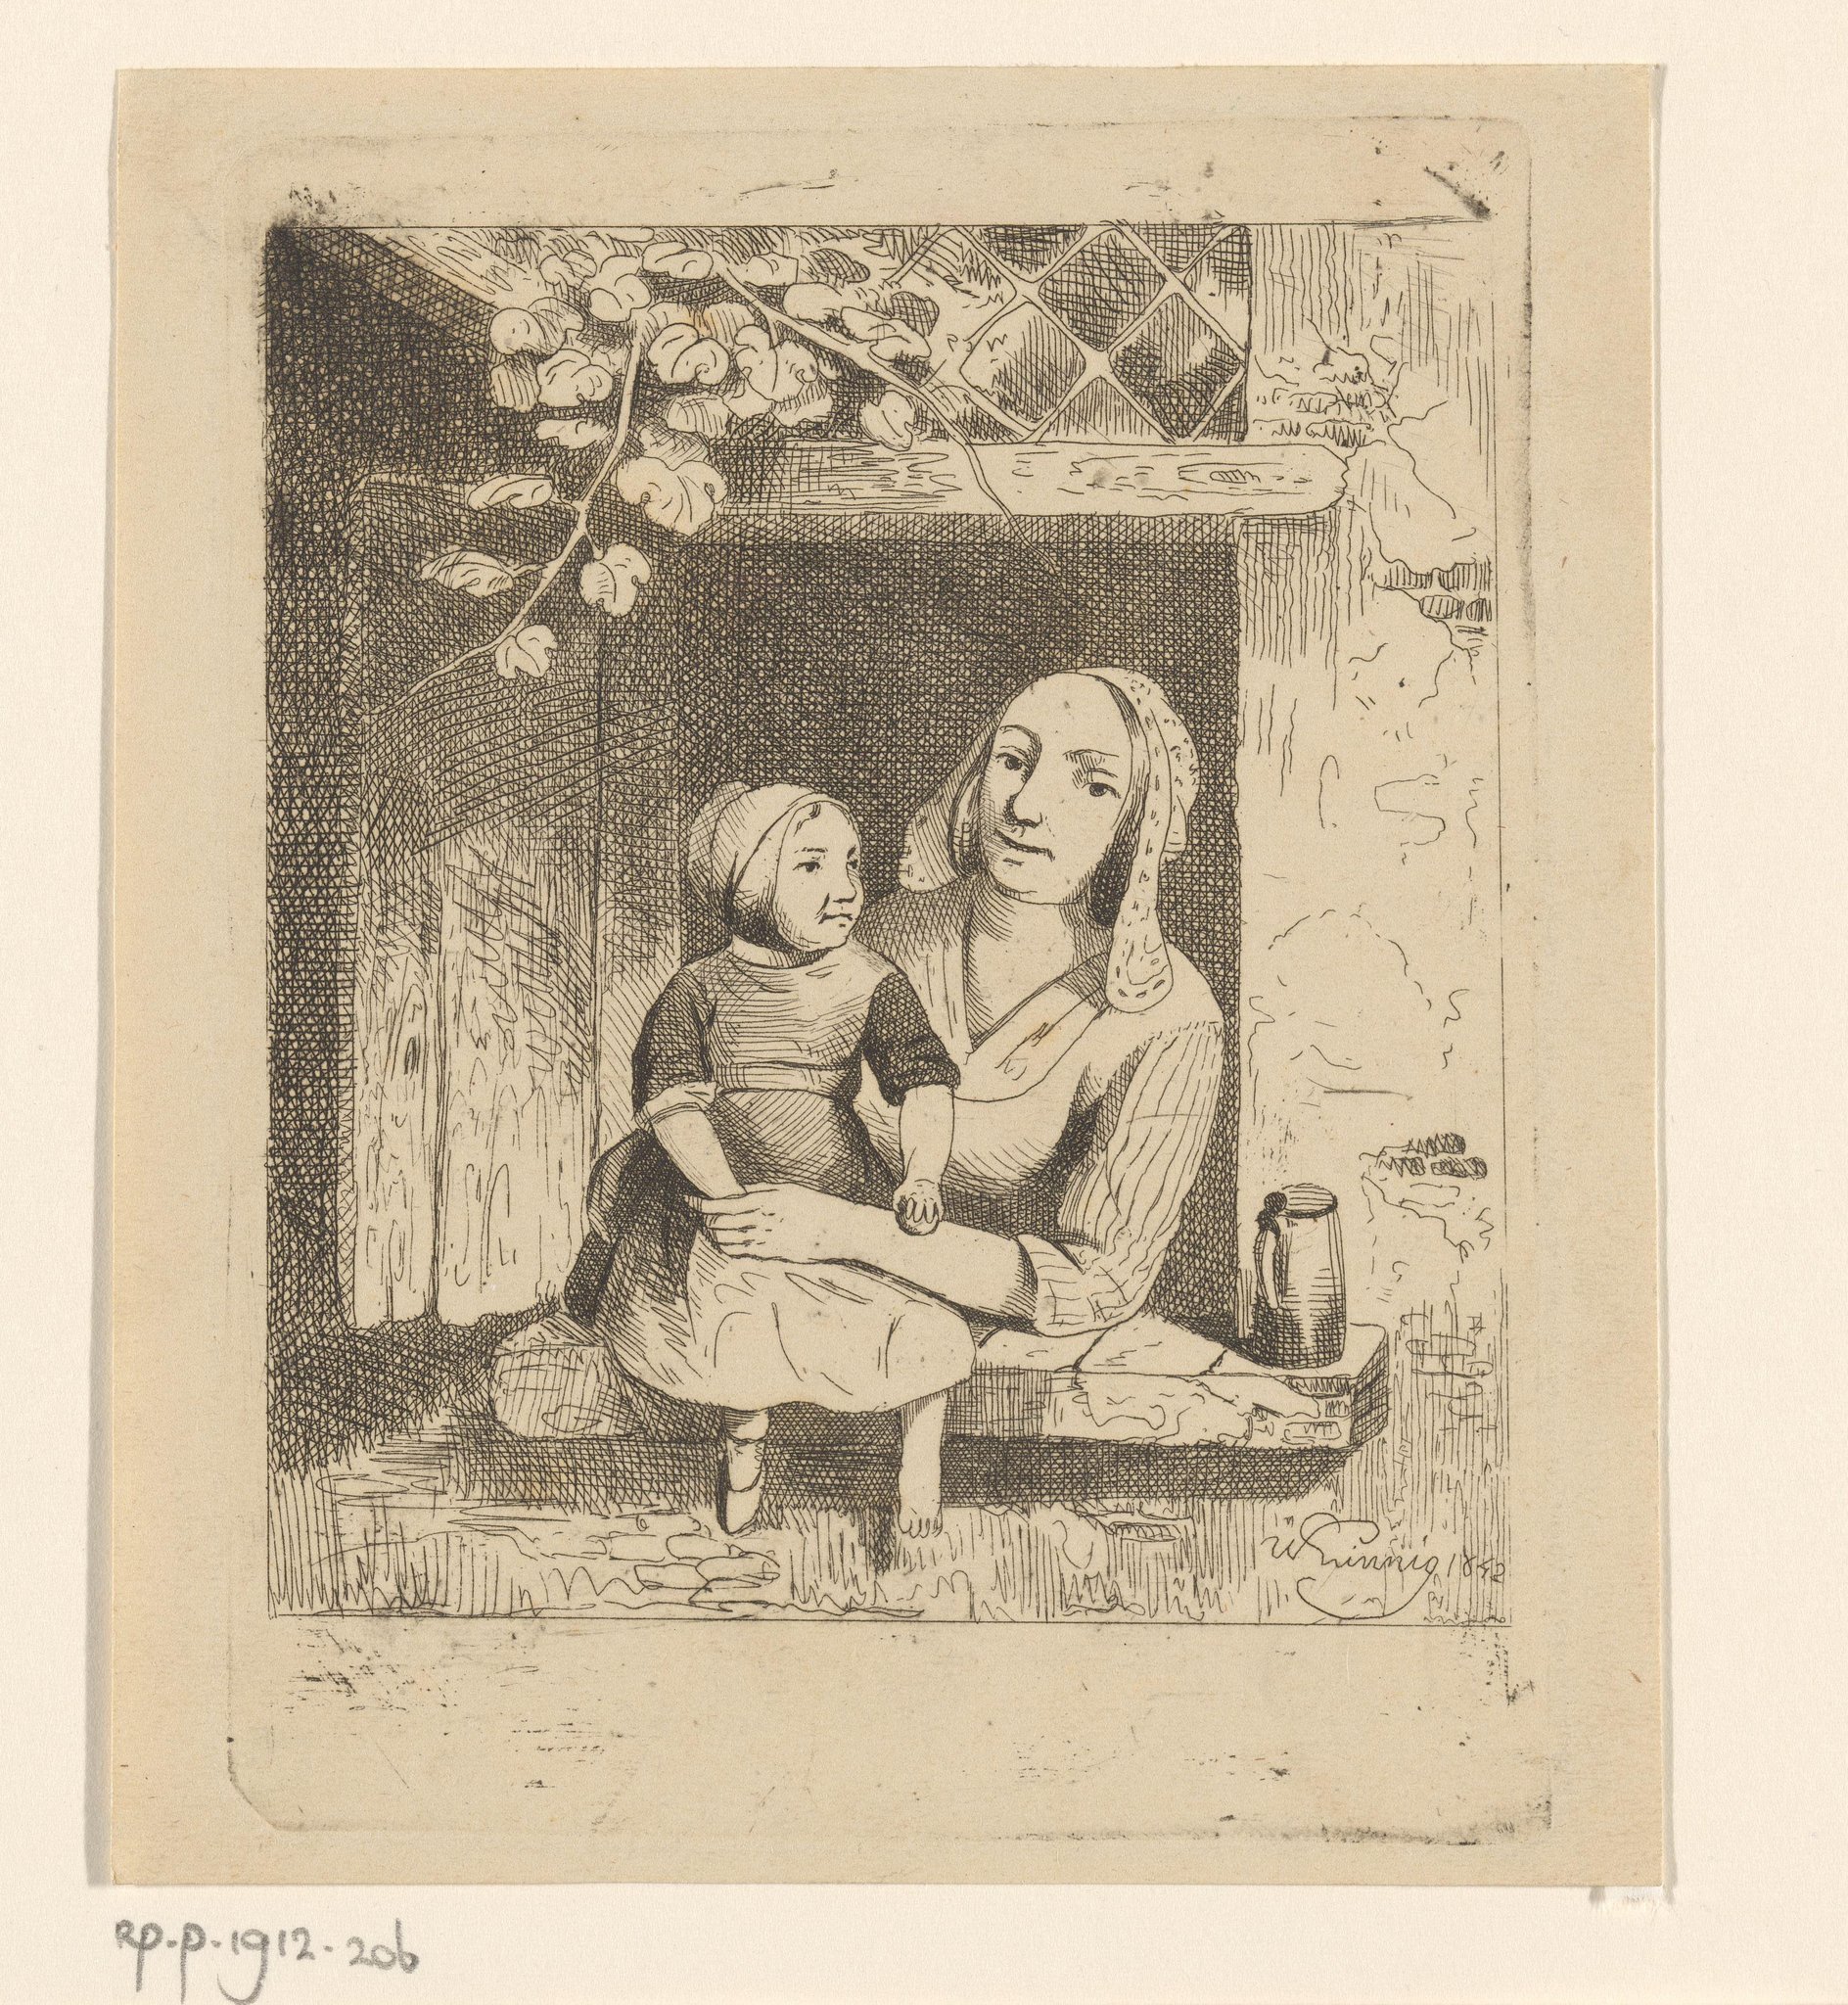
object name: print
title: Moeder houdt haar dochter vast, die op de vensterbank zit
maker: willem linnig (i)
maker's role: print maker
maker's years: 1819-1885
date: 1842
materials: paper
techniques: etching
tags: mother and baby or young child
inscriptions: collector's mark: Lugt 2228, collector's mark: Lugt 1485